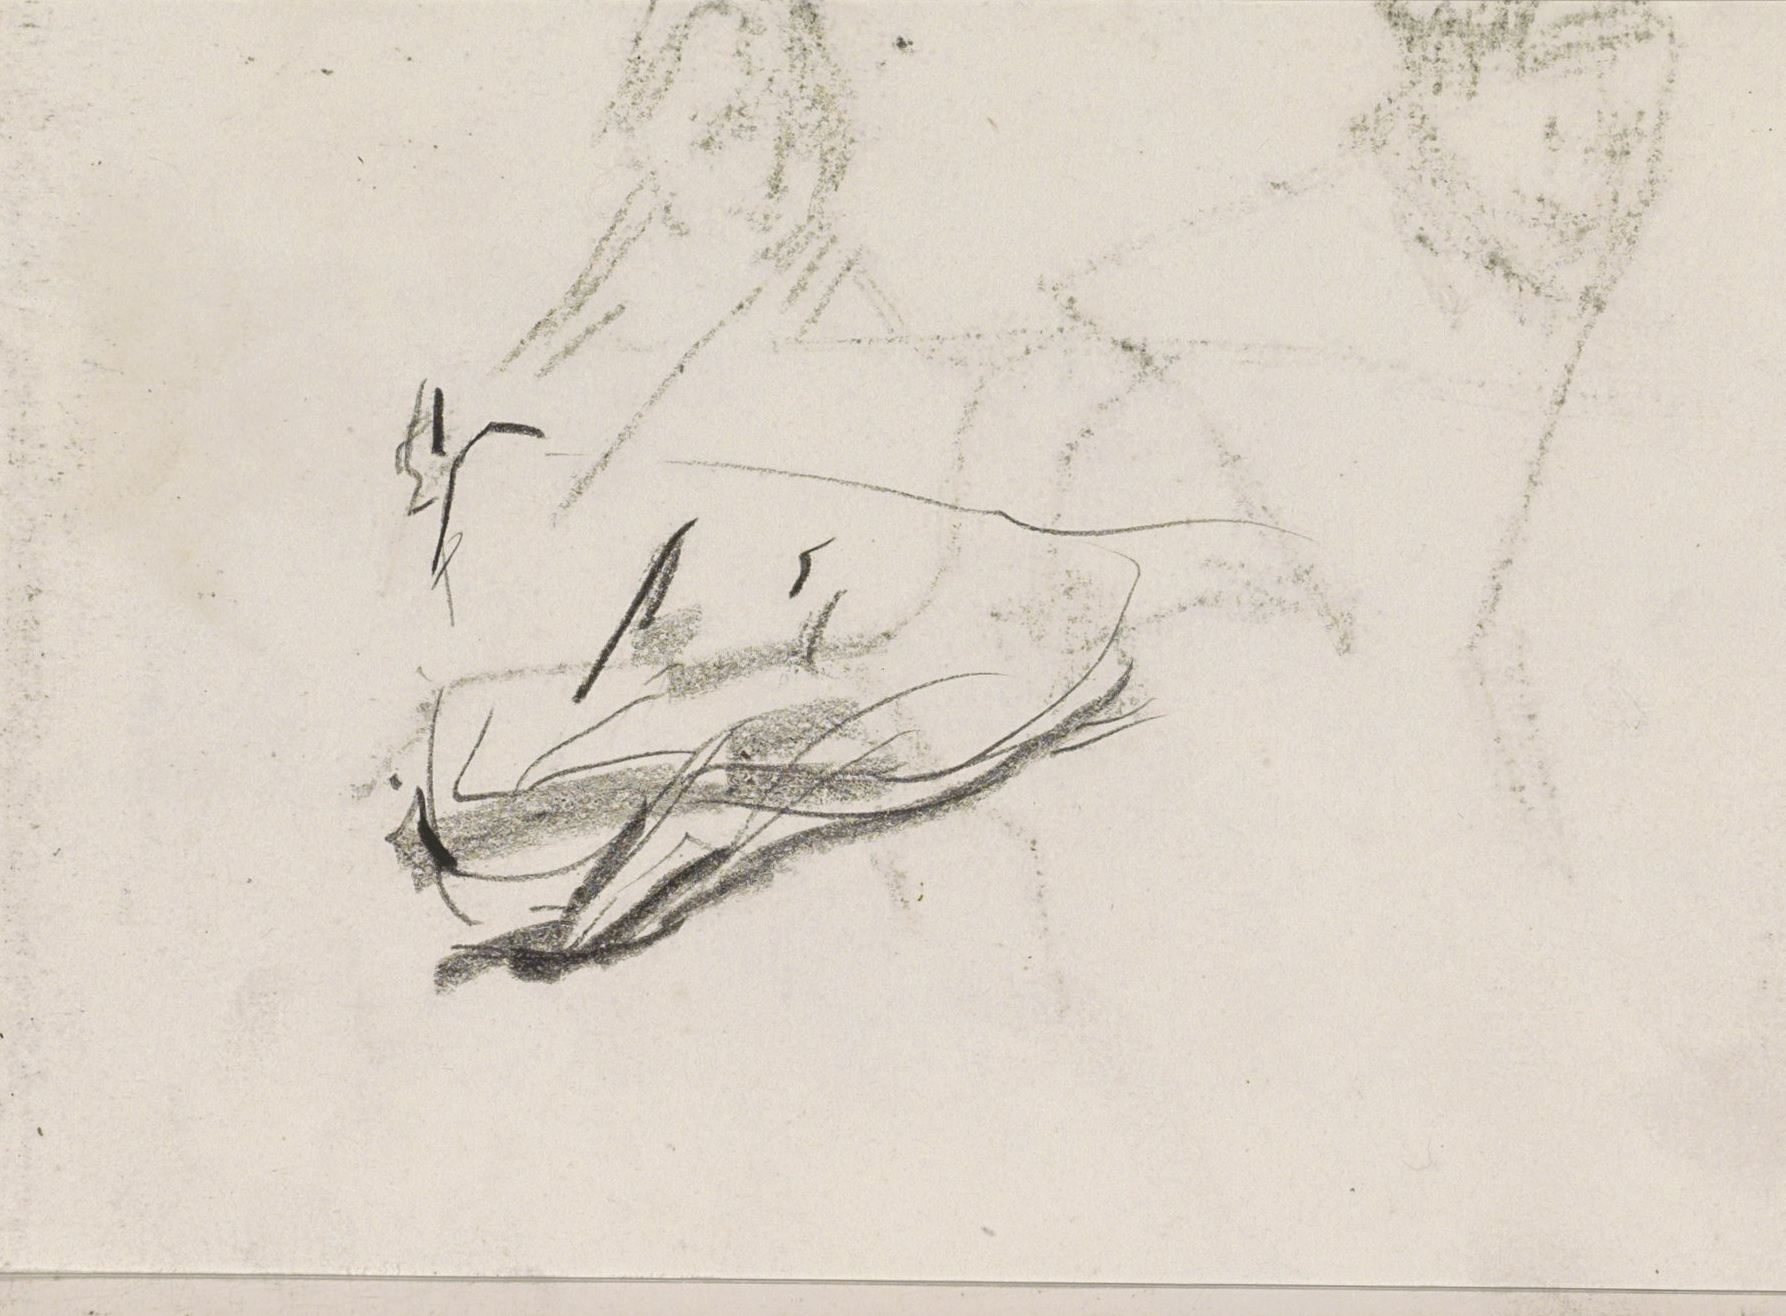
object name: sketchbook leaf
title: Onderlijf van een vrouw met rok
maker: isaac israels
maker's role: draughtsman, painter, print maker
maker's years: 1865-1934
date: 1886-1903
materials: chalk, paper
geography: amsterdam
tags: adult woman, skirt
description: Pagina 31 uit schetsboek XLVII met 52 pagina's.